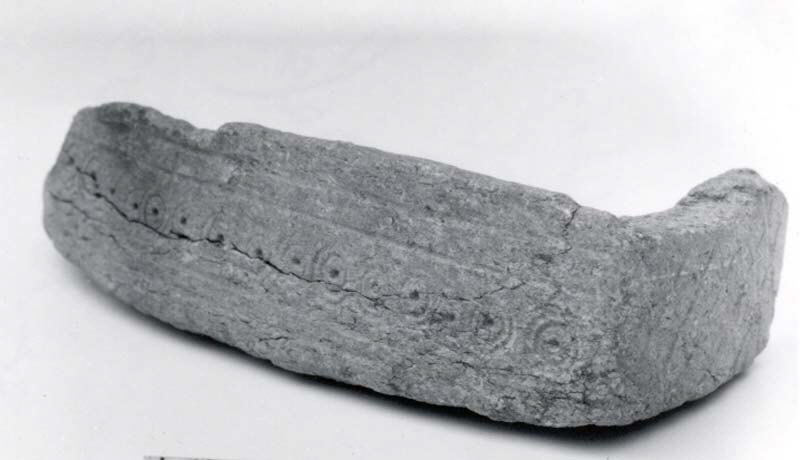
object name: lamp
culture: sasanian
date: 201-700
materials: stone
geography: mesopotamia